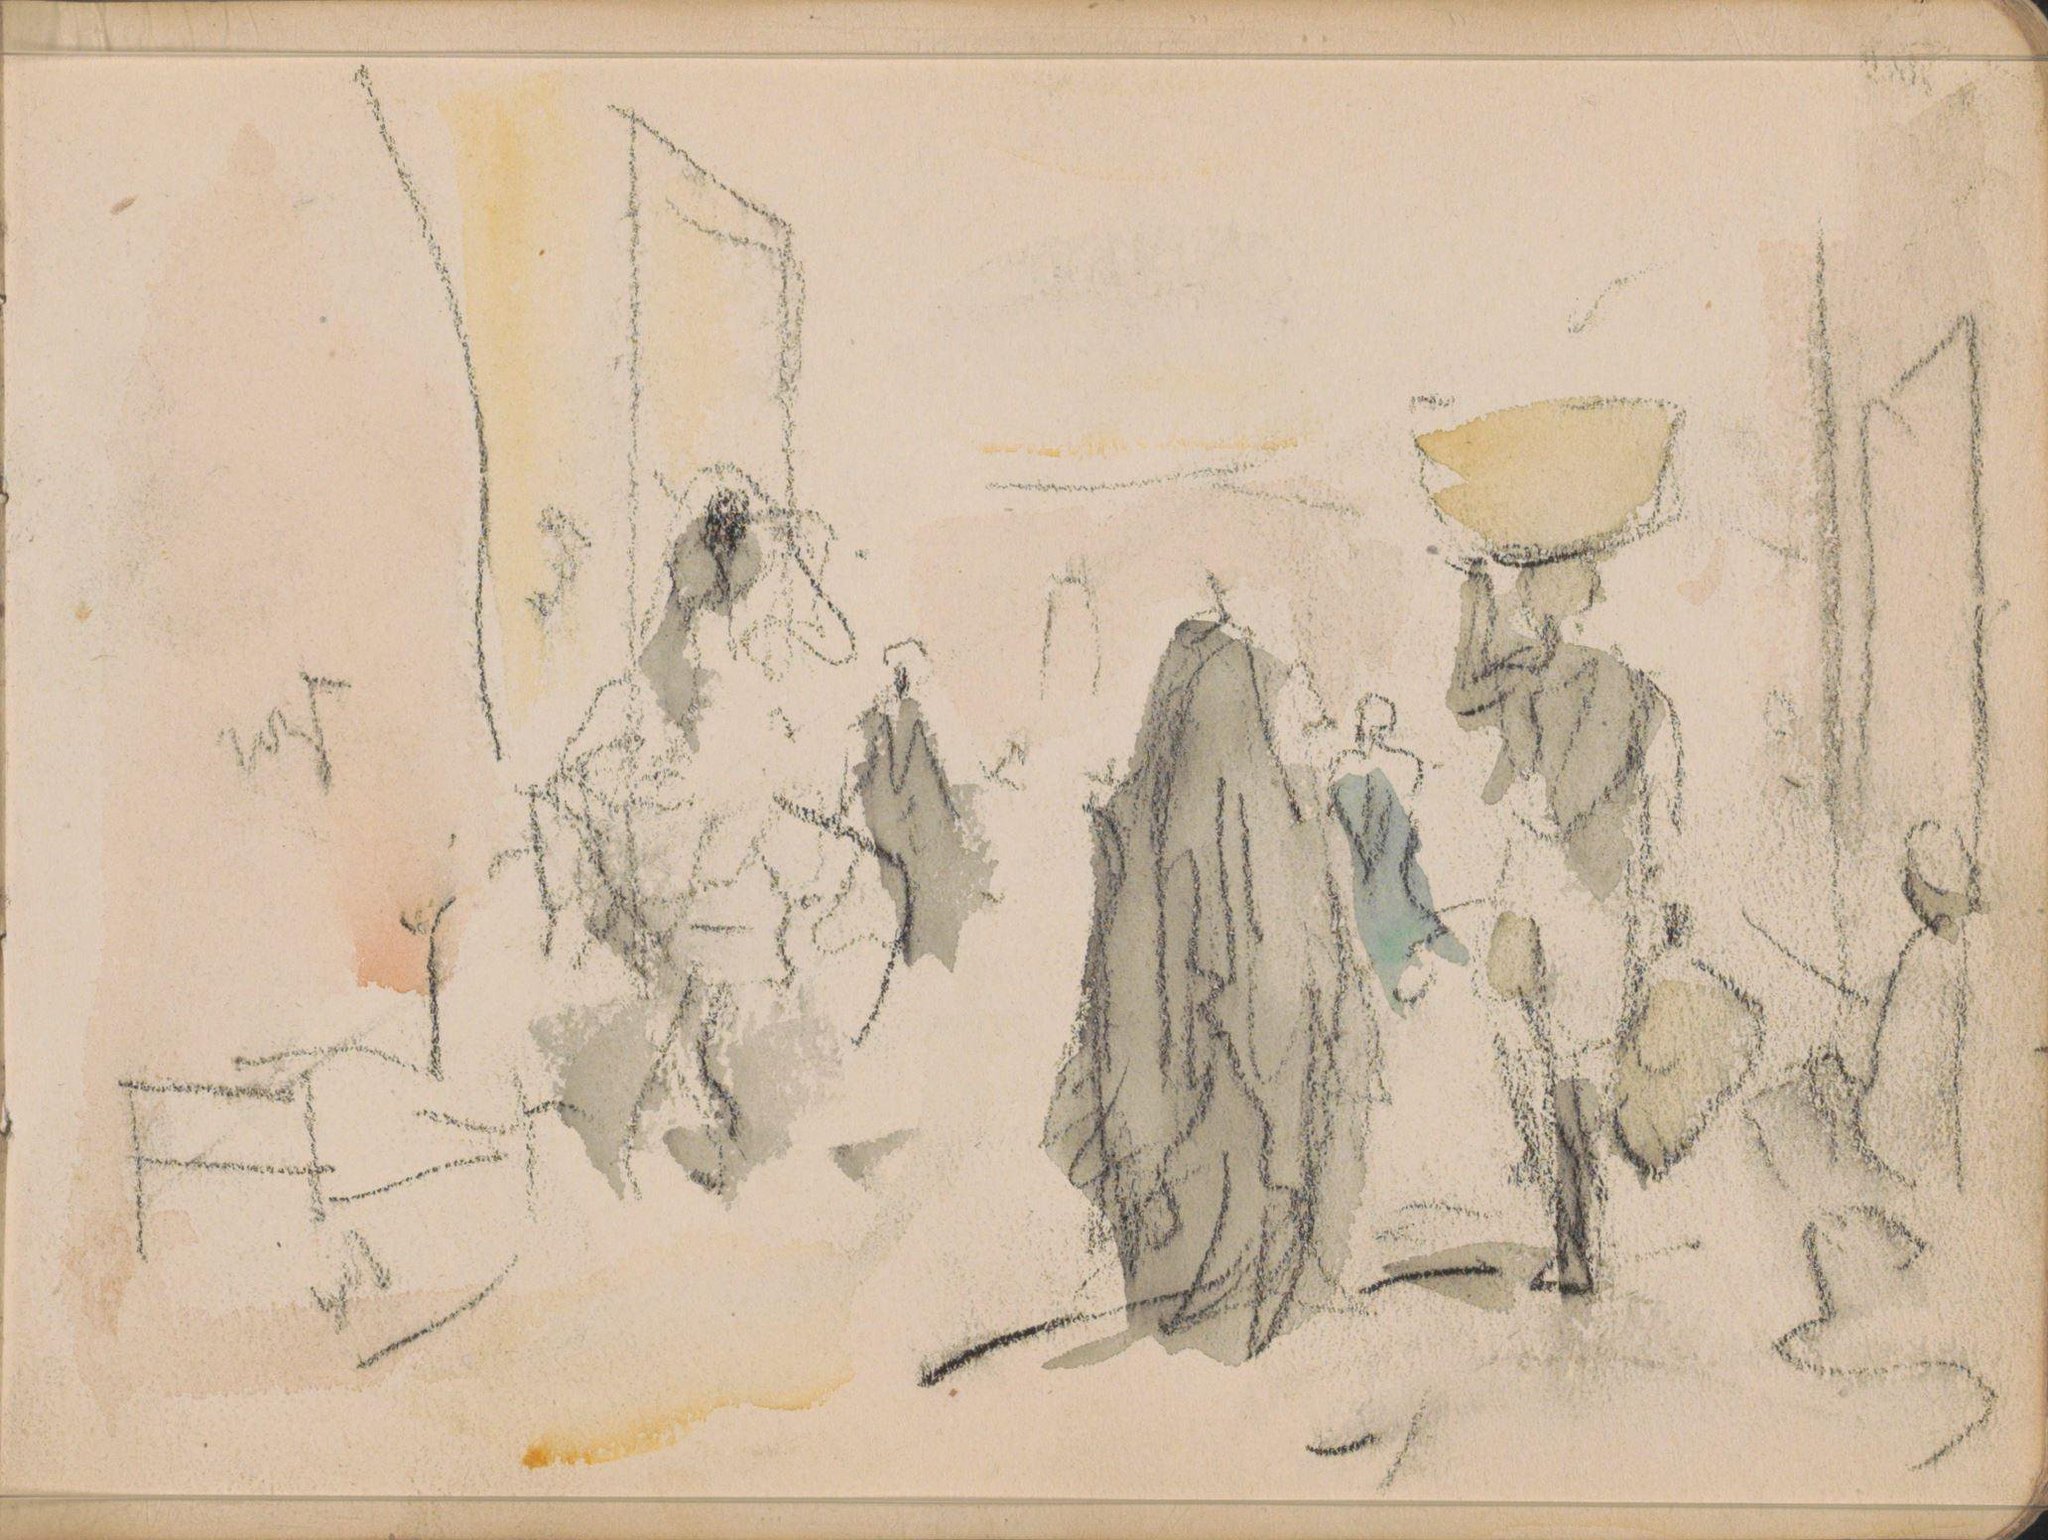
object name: sketchbook leaf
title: Straatscène in Luxor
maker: marius bauer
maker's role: draughtsman, print maker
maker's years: 1867-1932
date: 1919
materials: chalk, paper, watercolor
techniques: brush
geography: luxor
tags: africans, street (+ city(-scape) with figures, staffage)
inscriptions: kleurnotitie, handgeschreven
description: Op de voorgrond een man die een grote kom op het hoofd draagt. Pagina 28 uit een schetsboek met 28 bladen.